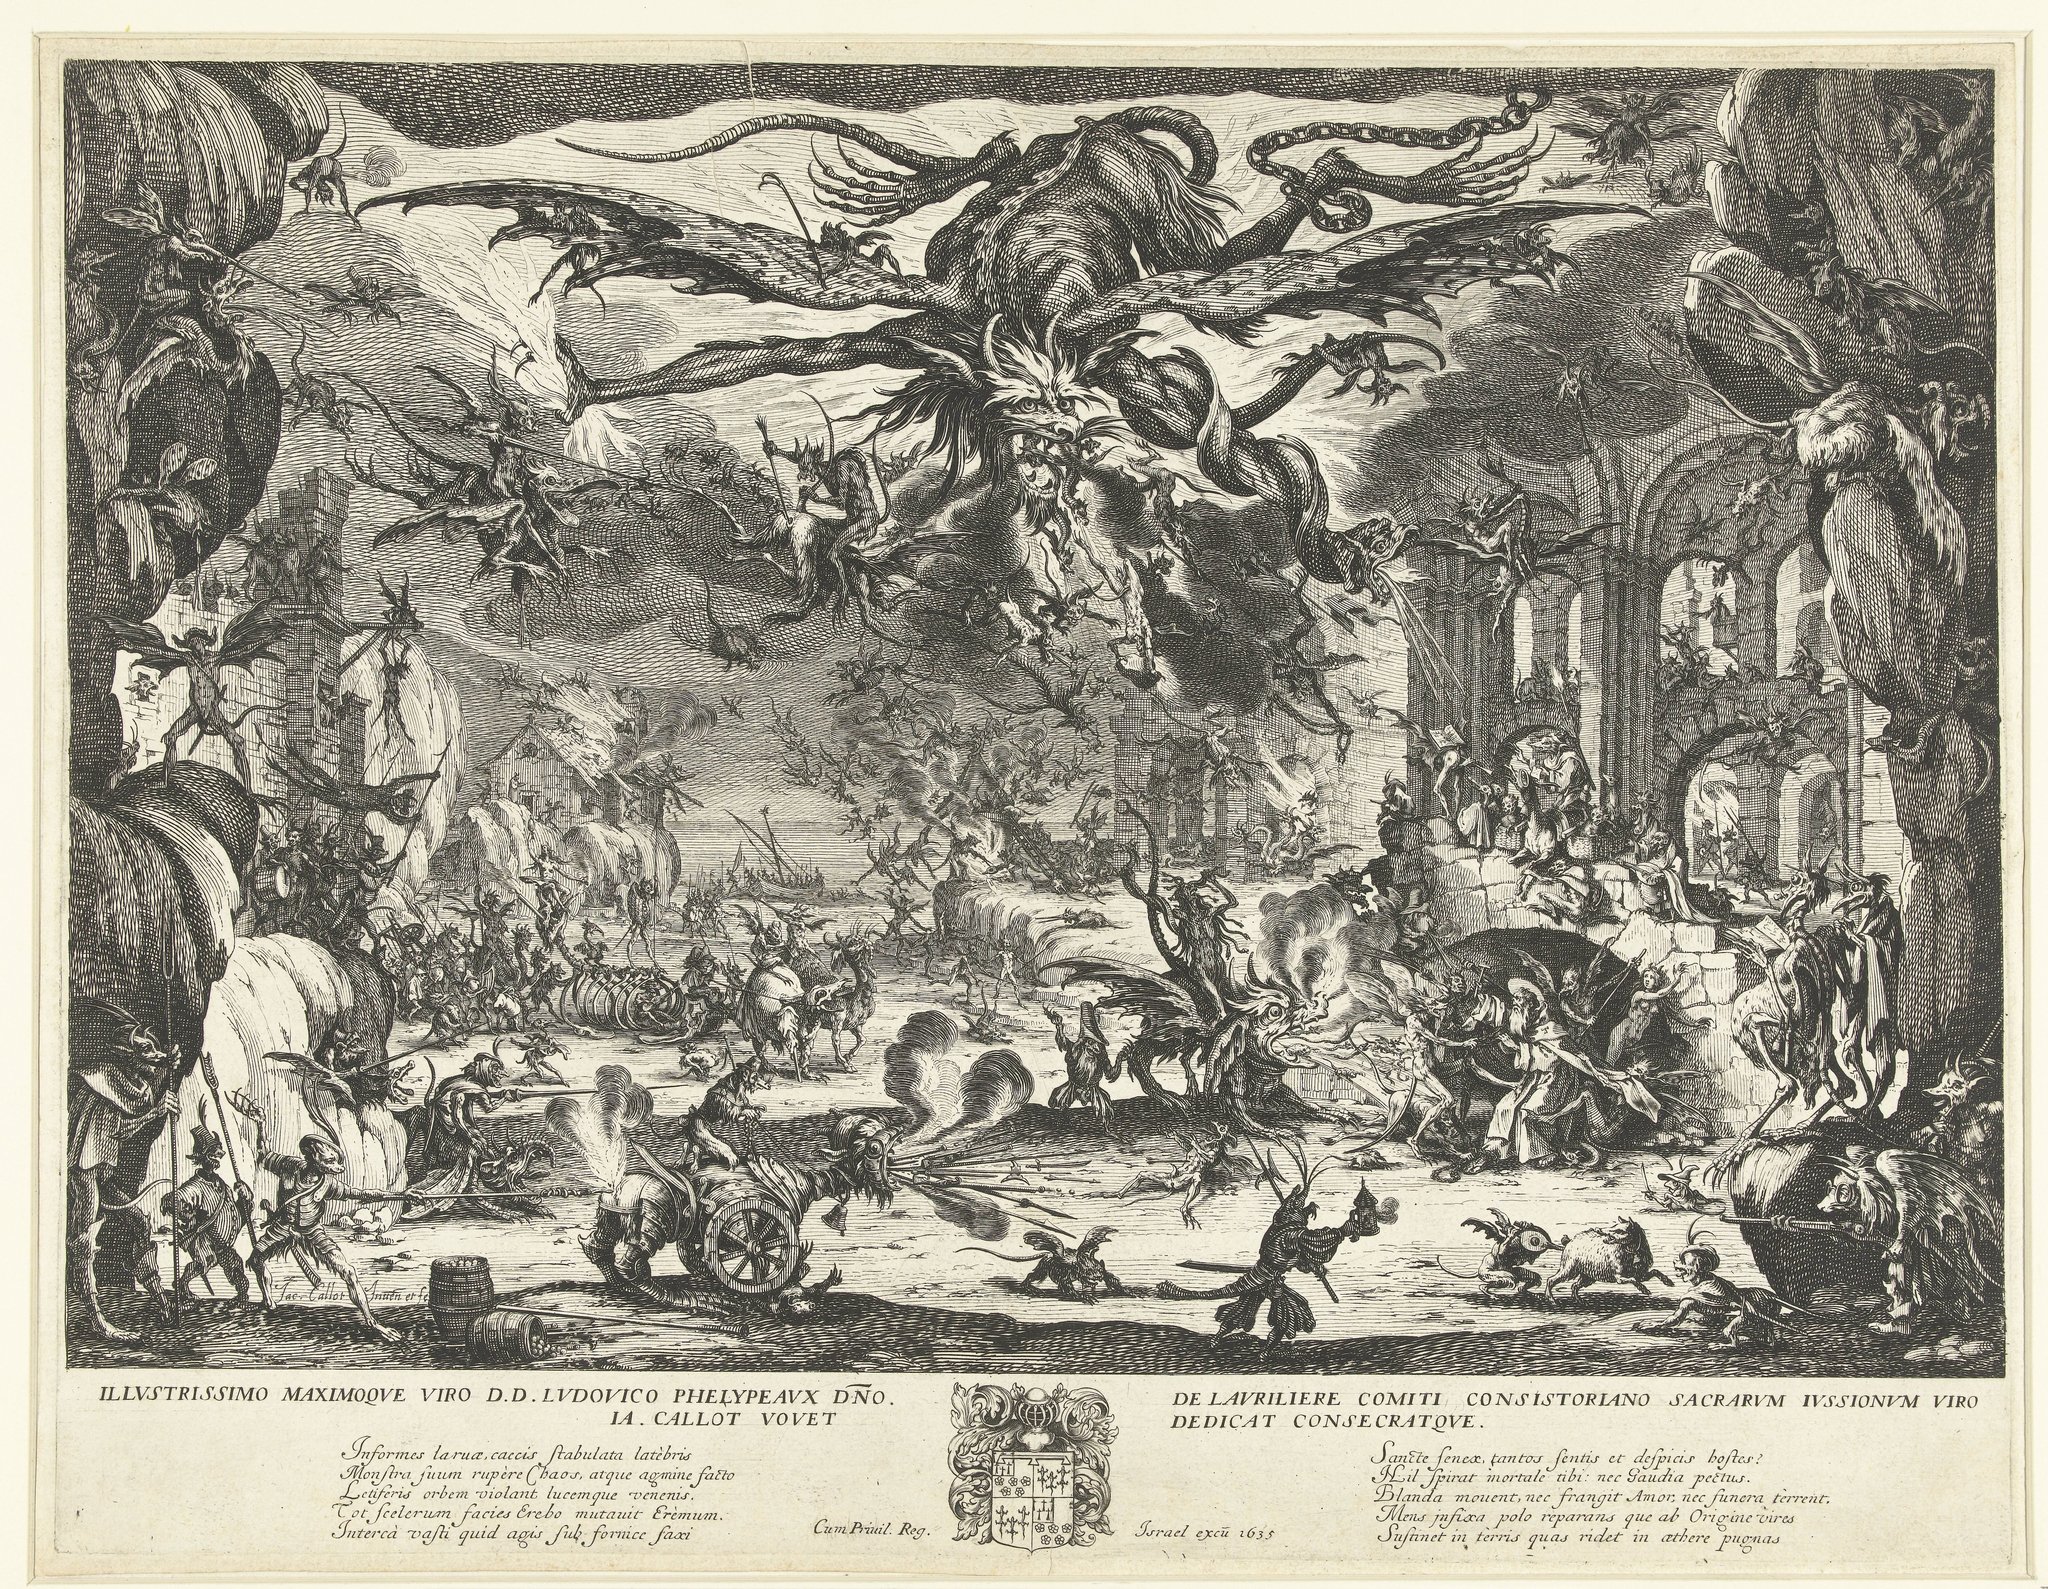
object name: print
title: De verzoeking van de Heilige Antonius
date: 1635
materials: paper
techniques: etching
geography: nancy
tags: st. antony abbot tormented by devils, attacking him on the ground or carrying him aloft, armorial bearing, heraldry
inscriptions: inscription: ‘D.L. No.5. / D.D.’, collector's mark: Lugt 240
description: In een rotsachtig landschap met enkele ruïneuze gebouwen zijn vele duivelse wezens bezig met brandstichting, vechten en martelen. Middenboven een opvallend groot, rookbrakend monster. Rechts op het middenplan de Heilige Antonius bij een kerker, lastig gevallen door demonen. Onder de voorstelling een Latijns onderschrift en een wapenschild.